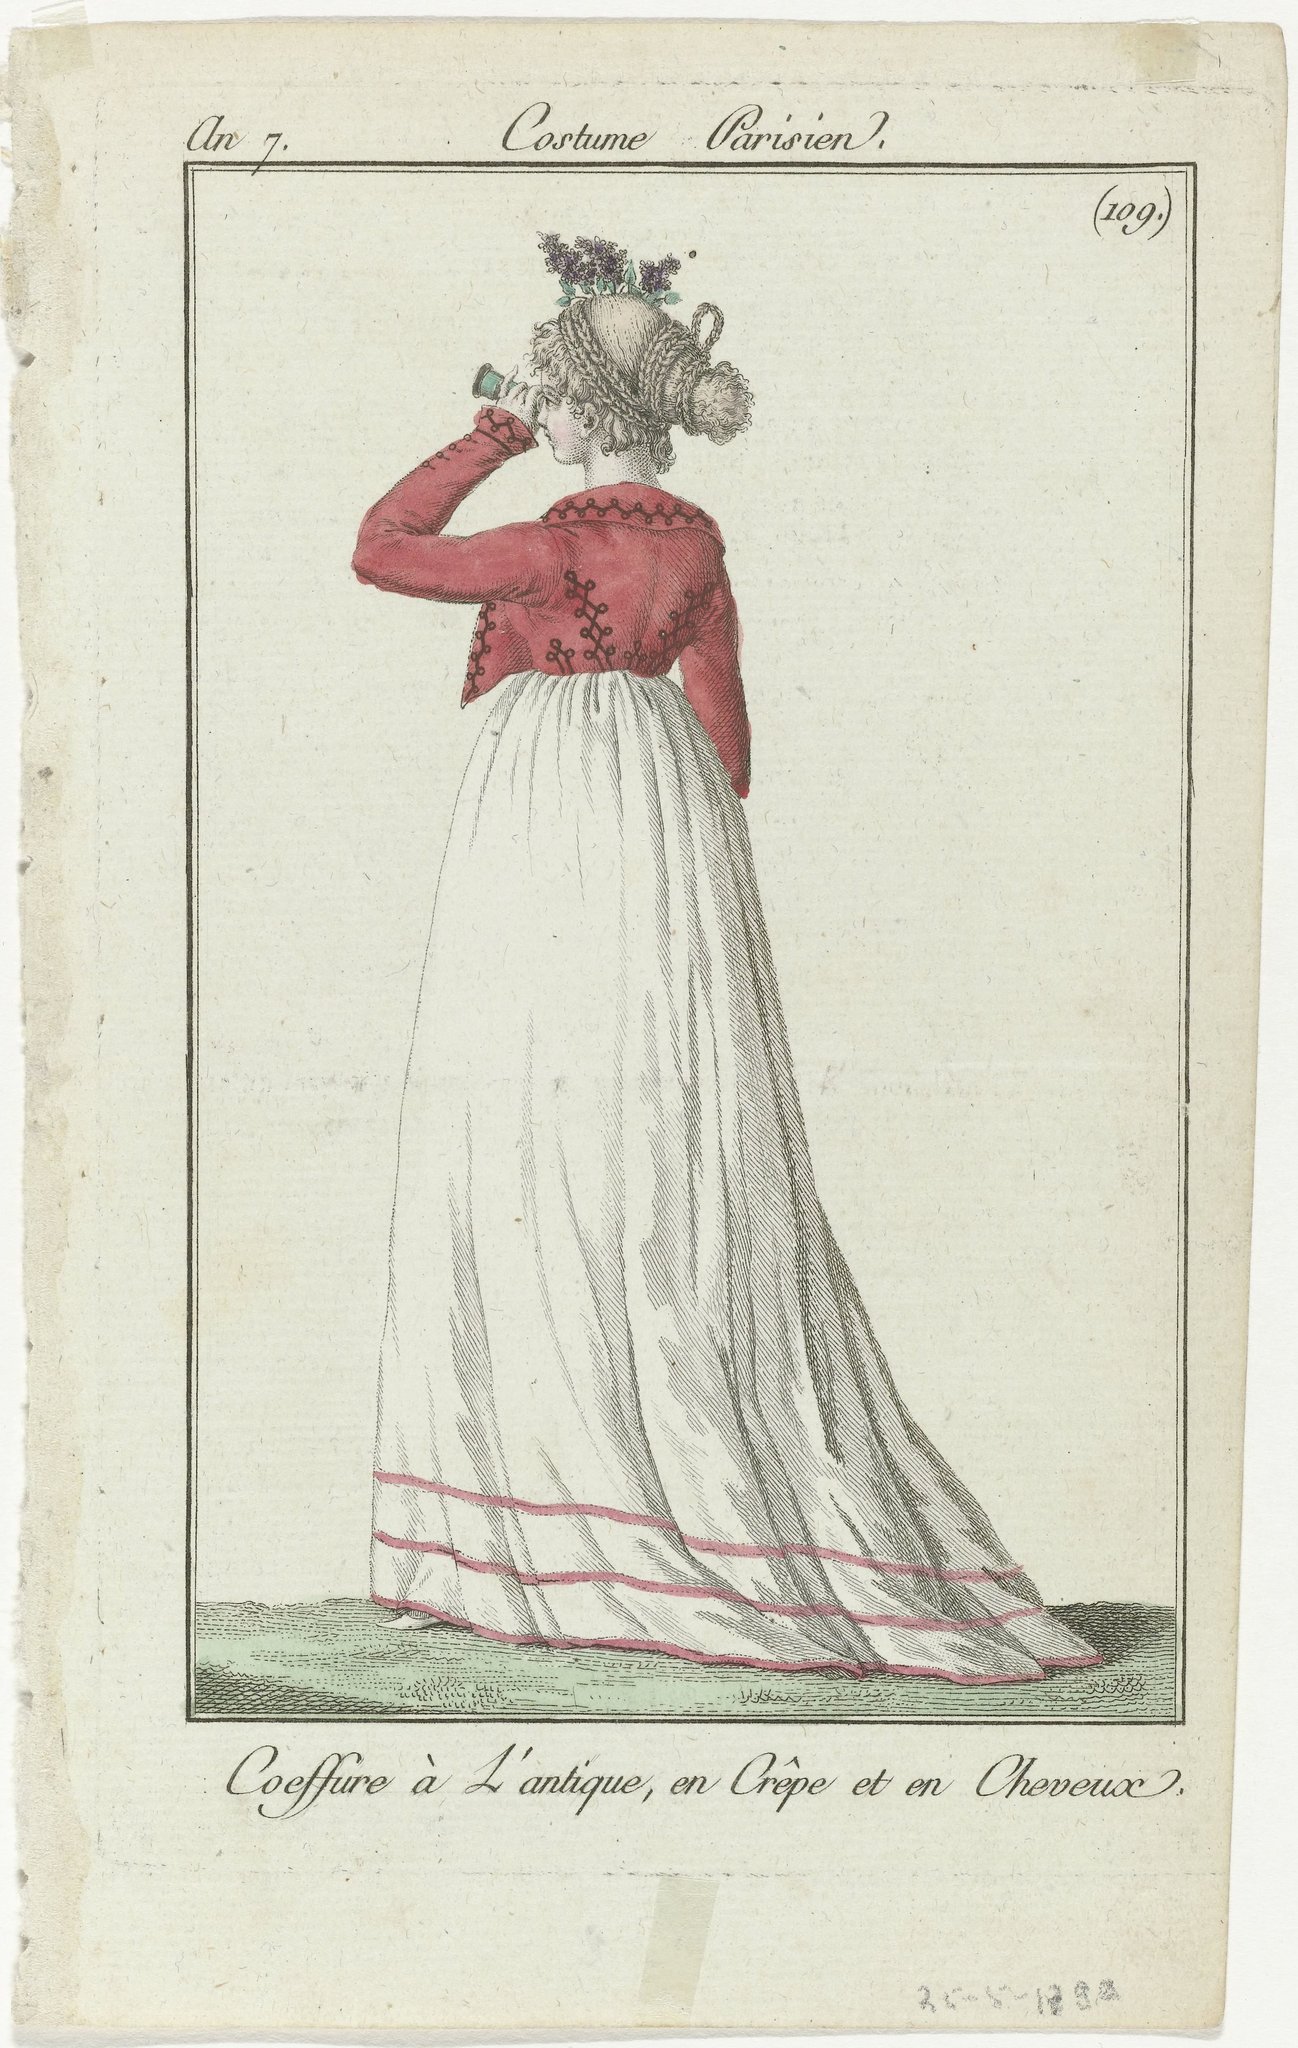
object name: fashion print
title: Journal des Dames et des Modes, Costume Parisien, 29 mai 1799, An 7 (109) : Coeffure à l'antiqu (...)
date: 1799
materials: paper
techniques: engraving, hand coloring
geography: paris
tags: cut flowers; nosegay, bunch of flowers, monocle, single lorgnette, clothing for the upper part of the body (spencer) (+ women's clothes), fashion plates, shoes, sandals (+ women's clothes), dress, gown (+ women's clothes)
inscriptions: caption: ‘Coeffure à l'antique, en Crêpe et en Cheveux.’, title: ‘Costume Parisien.’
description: Staande vrouw, op de rug gezien, kijkend door een verrekijker. 'Coeffure à l'antique', bestaande uit crêpe en haar. Zij draagt een spencer met lussenmotief op een rok met sleepje. De prent maakt deel uit van het modetijdschrift Journal des Dames et des Modes, uitgegeven door Sellèque, Parijs, 1797-1839.